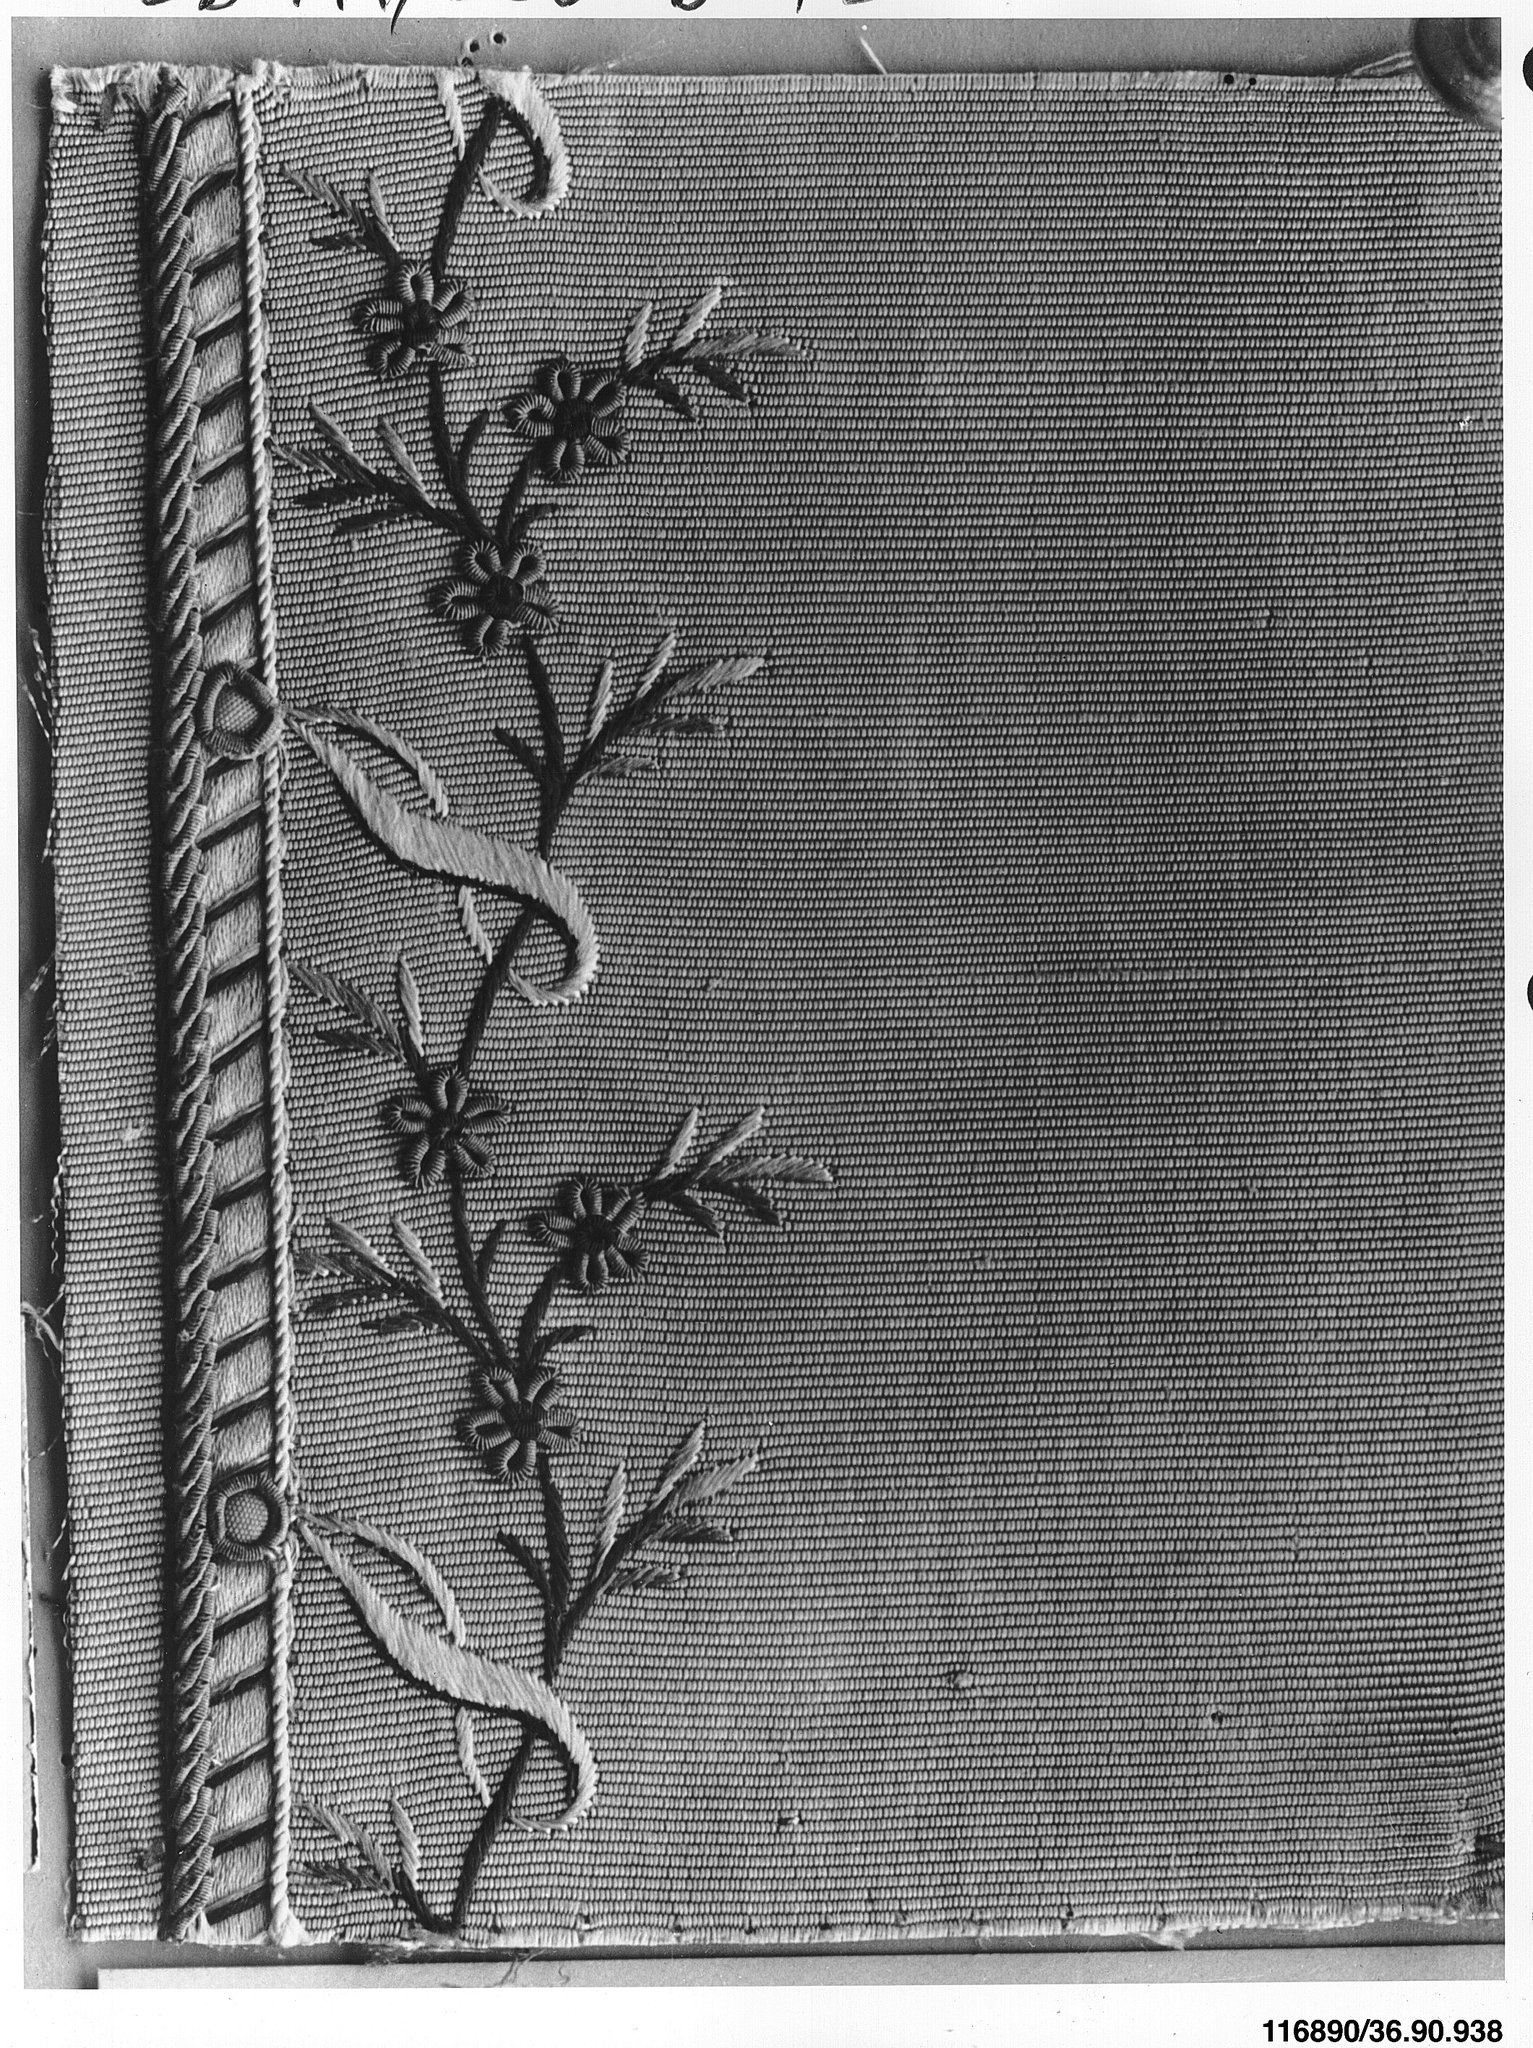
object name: sample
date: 1801-1833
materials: metal thread, silk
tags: flowers